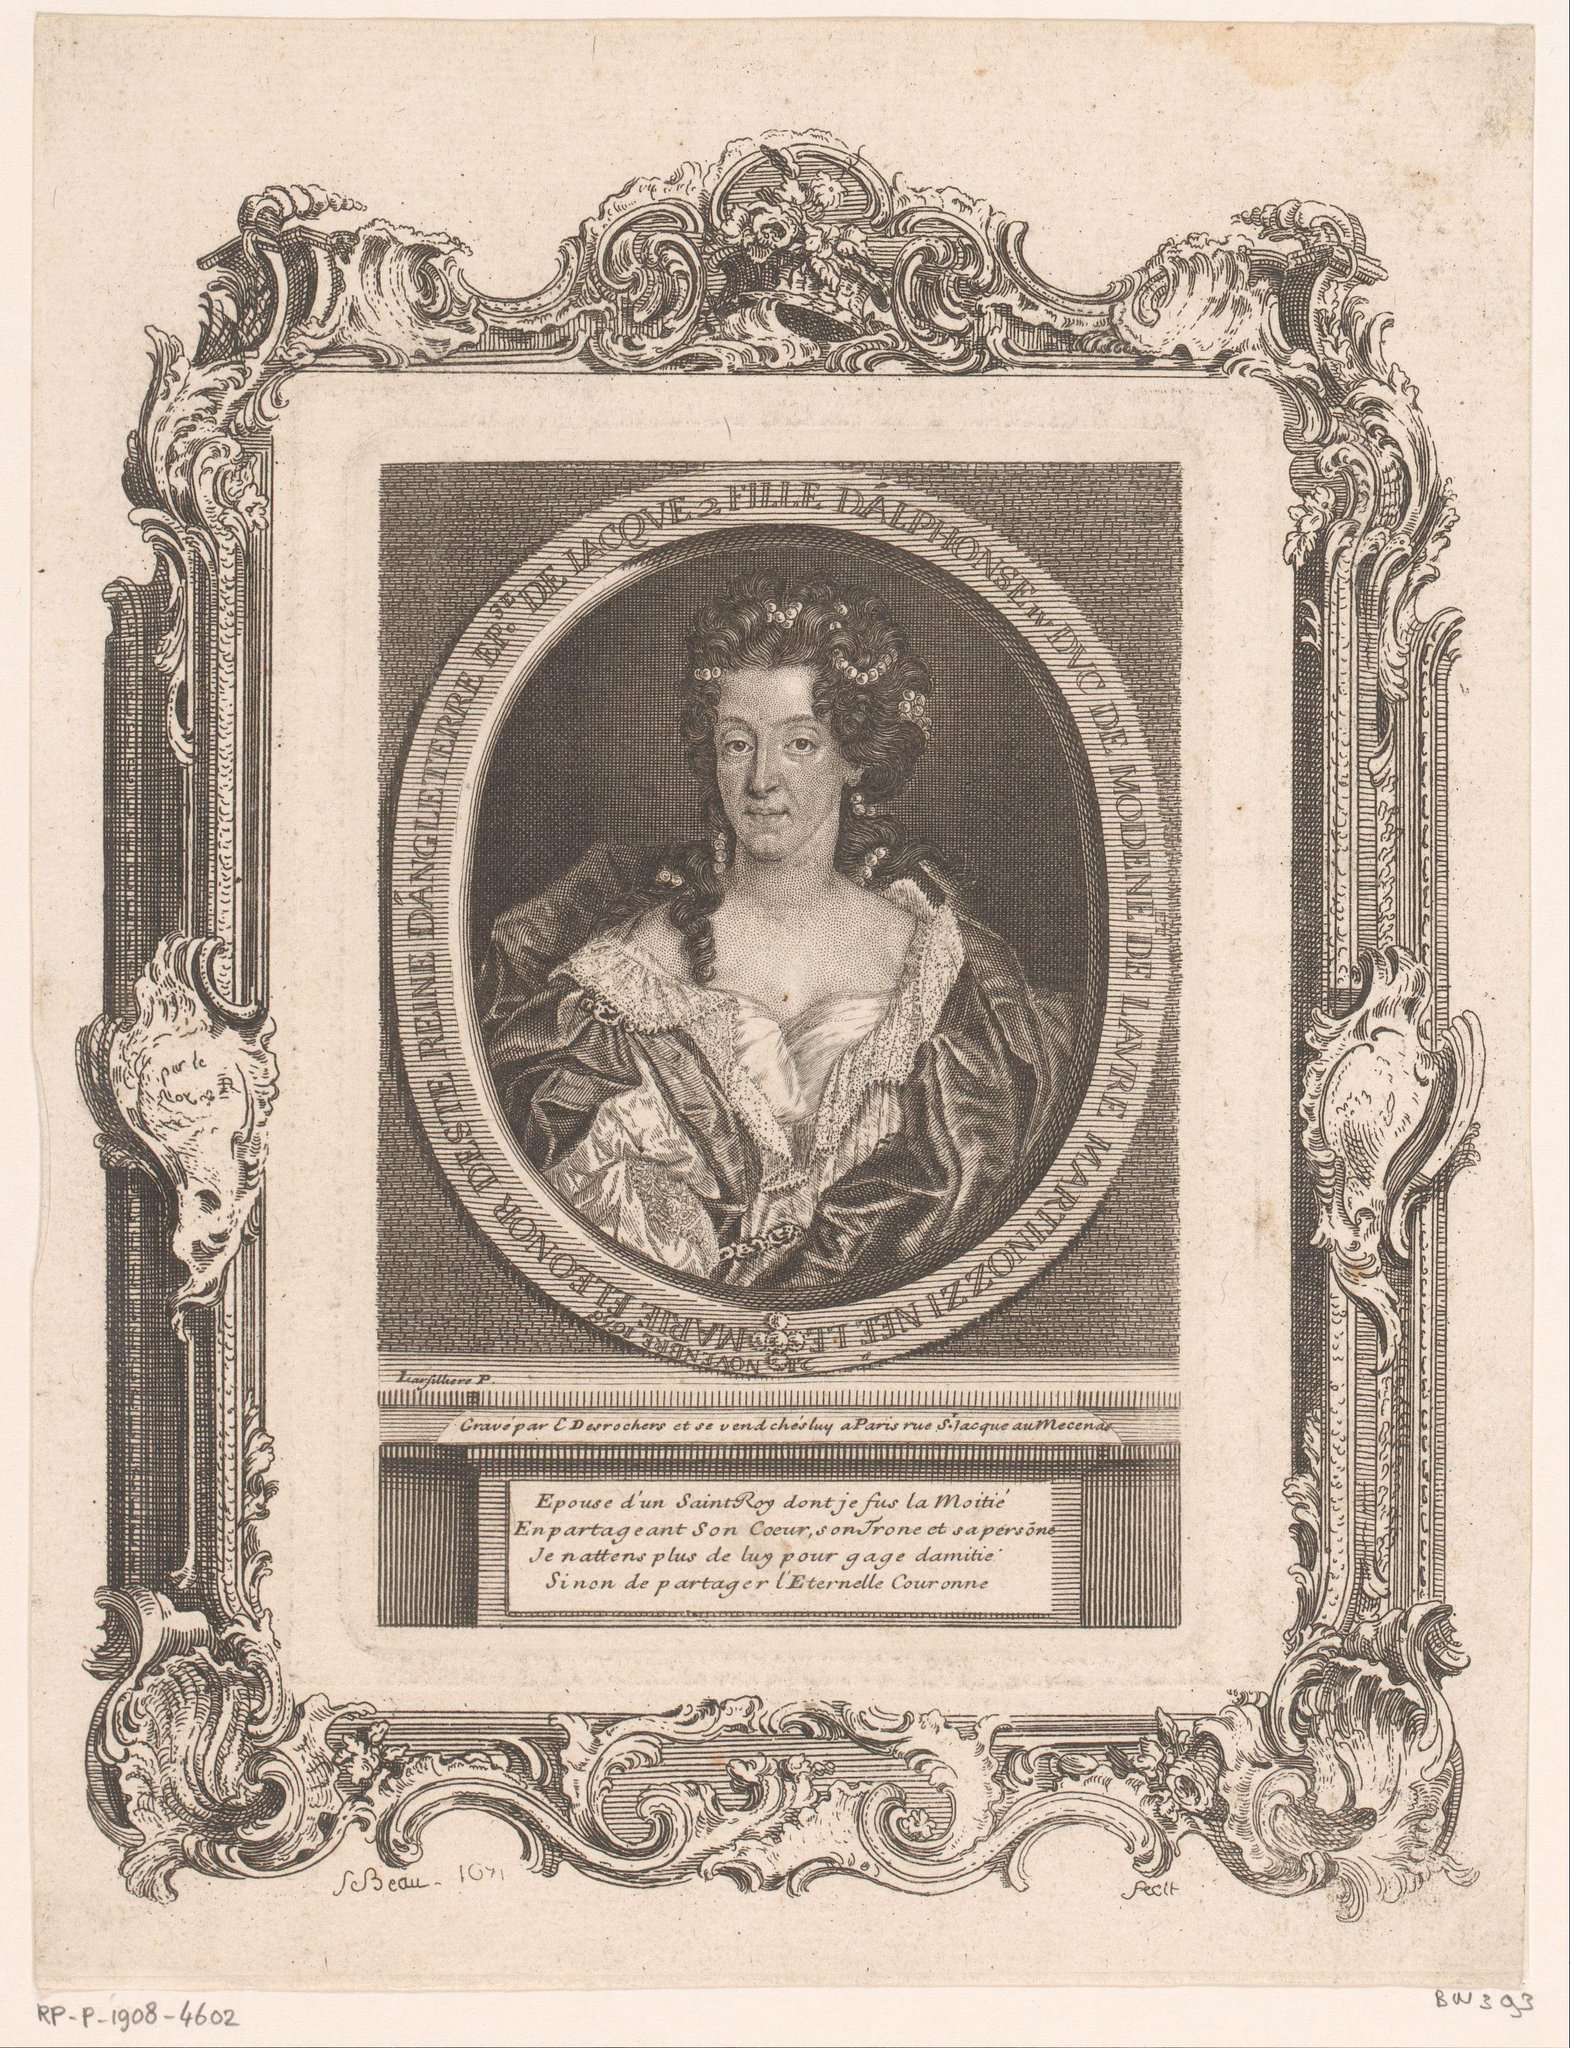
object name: print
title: Verzameling portretten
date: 1726-1761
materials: paper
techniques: engraving, etching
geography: france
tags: paris, historical persons, queen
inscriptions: collector's mark: Lugt 2228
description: Behoort waarschijnlijk tot een serie portretten, grotendeels door Etienne Desrochers, getiteld: 'Recueil de portraits de personnes qui se sont distinguées tant dans les Armes que dans Belles-Lettres et les Arts, comme aussi la famille royale de France et autres cours étrangères'. De serie werd initieel uitgegeven door Desrochers en aangekondigd in 'Mercure' in mei 1726, p. 985. Echter was Desrochers reeds enkele jaren eerder begonnen met het uitgeven van de serie. Na de dood van Desrochers werd de serie voortgezet door Gilles Edme Petit. Een latere staat werd uitgegeven door Jean François Daumont in Parijs.